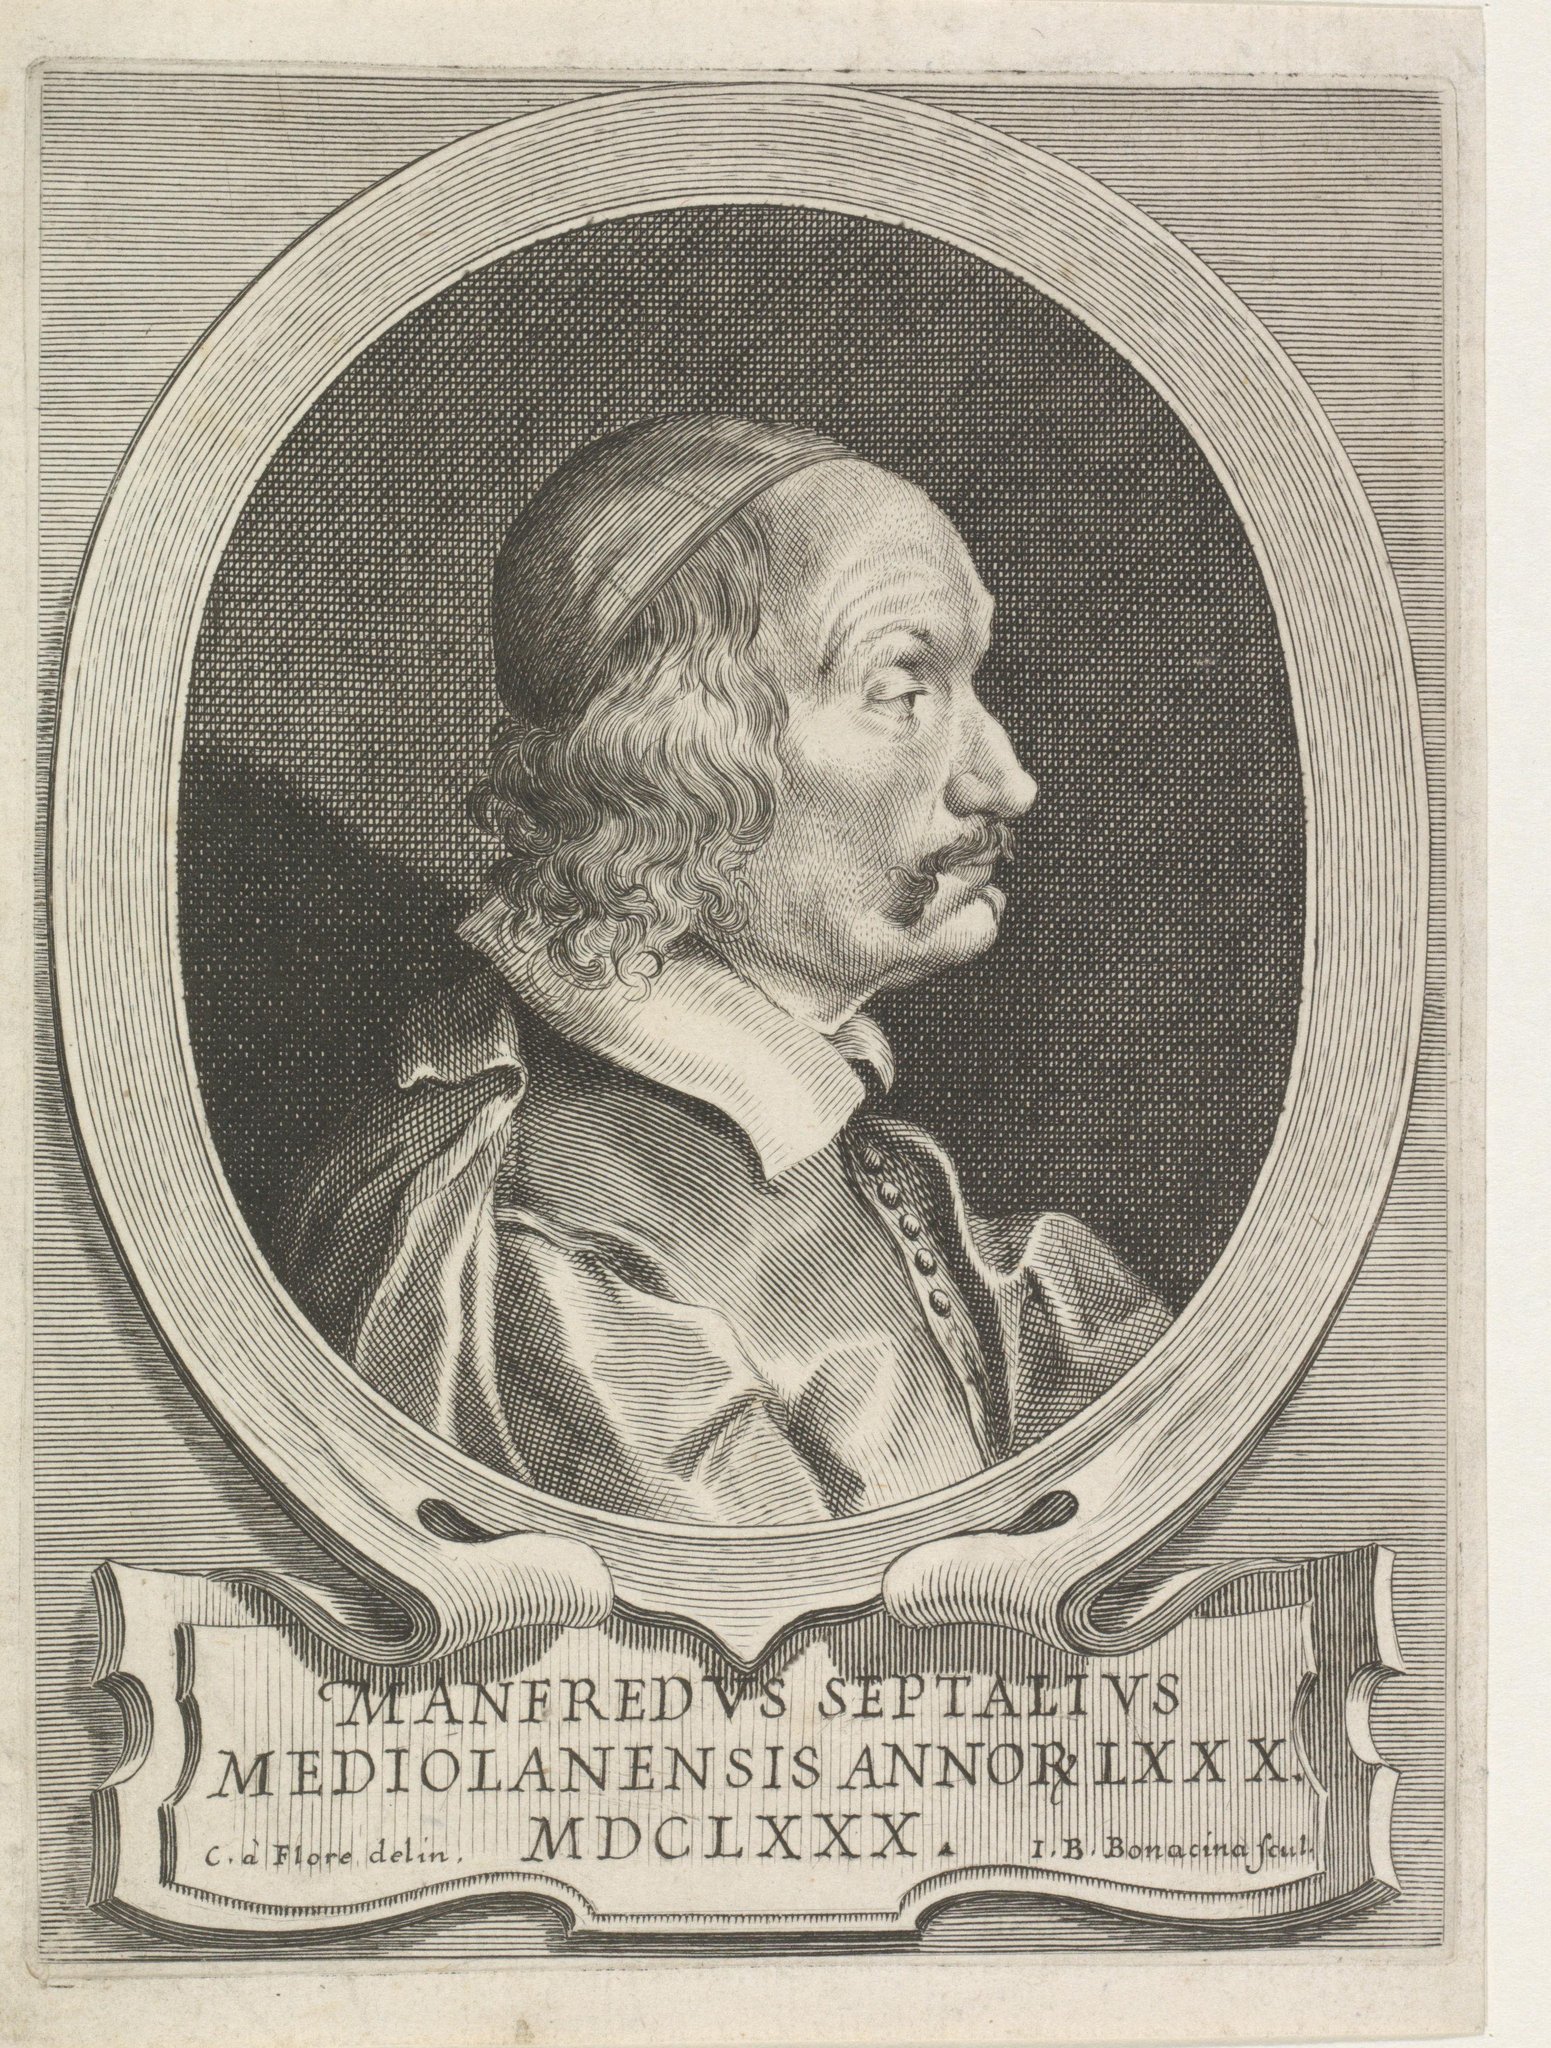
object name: print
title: Portret van Manfred Septalius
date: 1625-1669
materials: paper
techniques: engraving, etching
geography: italy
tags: historical persons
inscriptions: collector's mark: Lugt 2228